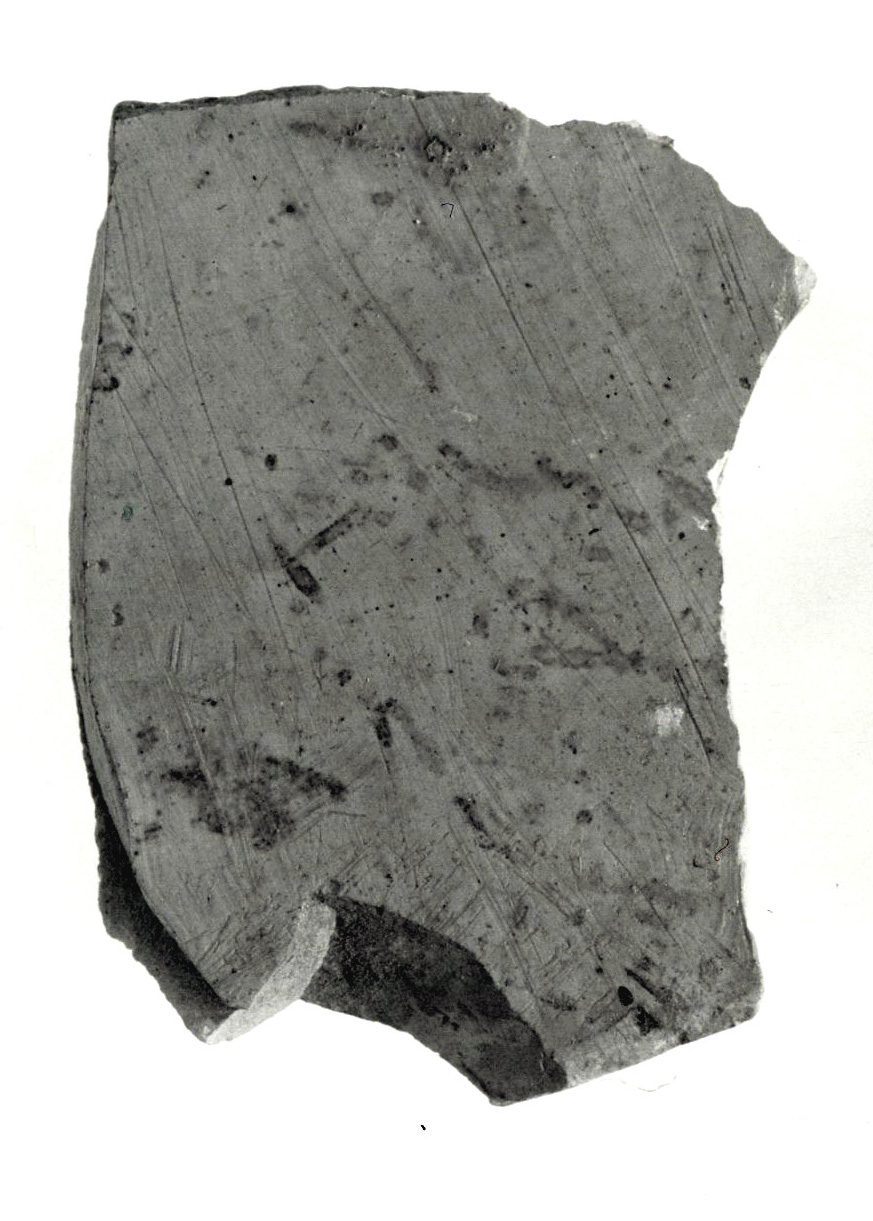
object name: relief, tomb of nespekashuty, wall casing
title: Wall casing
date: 664-610 BCE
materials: limestone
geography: egypt